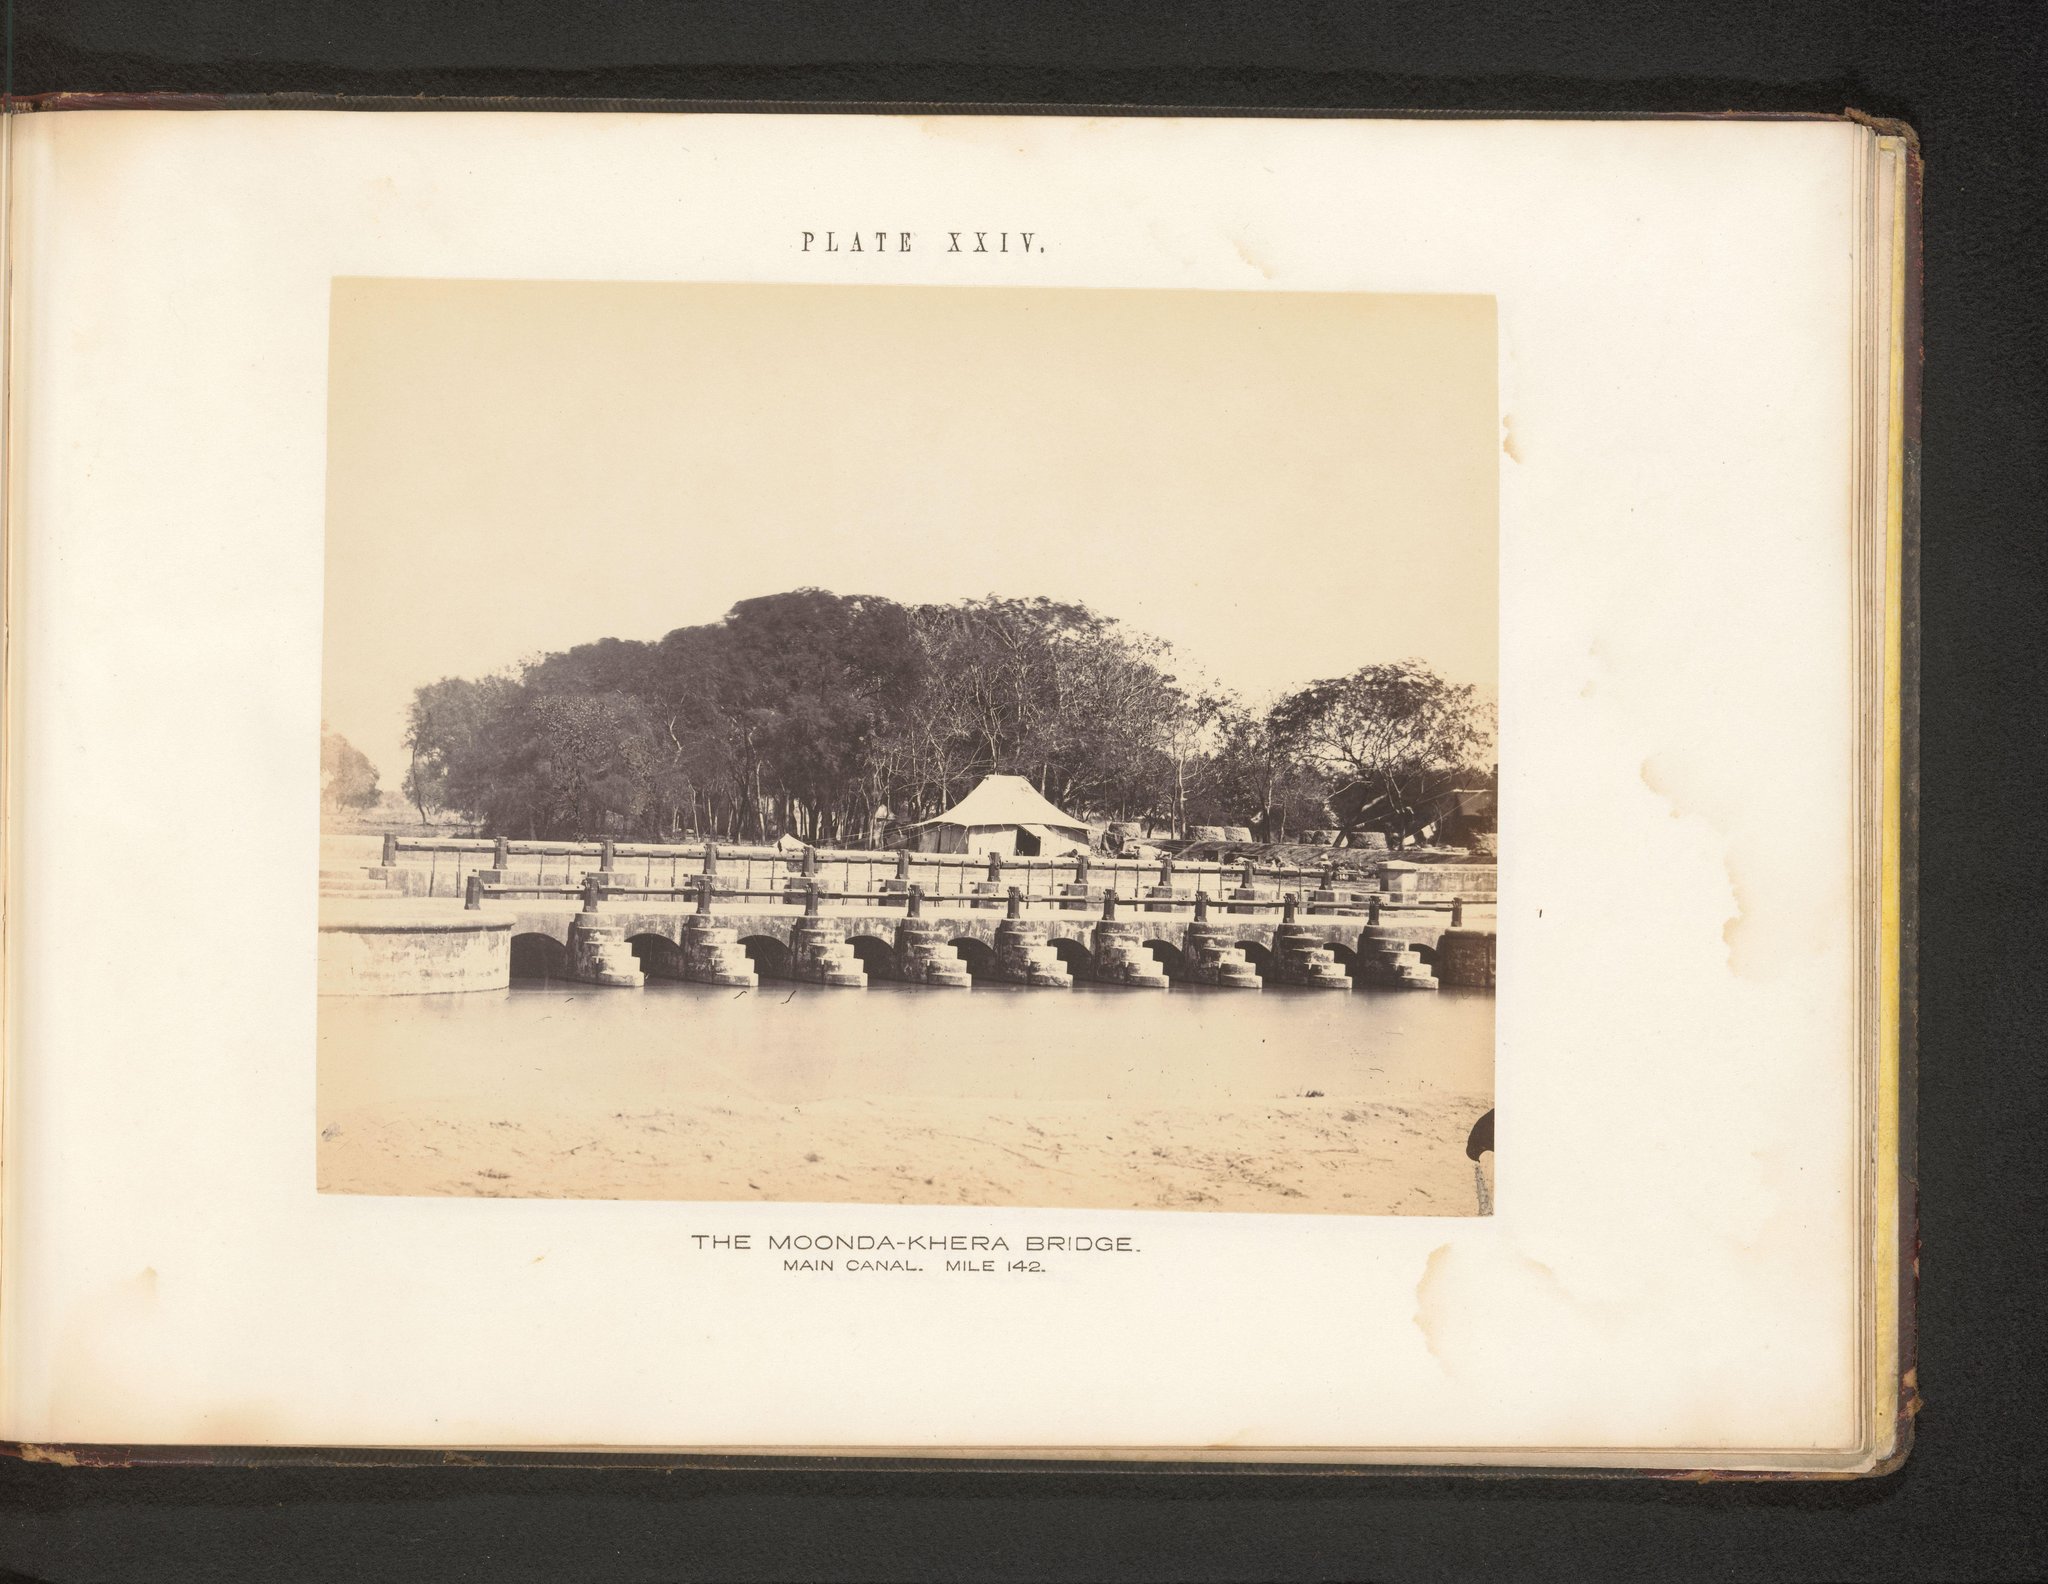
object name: page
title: Gezicht op een brug over de Ganges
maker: thomas george glover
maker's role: fotograaf, luitenant-kolonel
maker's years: 1825-1881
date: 1862-1867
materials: photographic support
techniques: albumen print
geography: india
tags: river, bridge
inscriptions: inscription: ‘main canal. mile 142.’, inscription: ‘Plate XXIV’